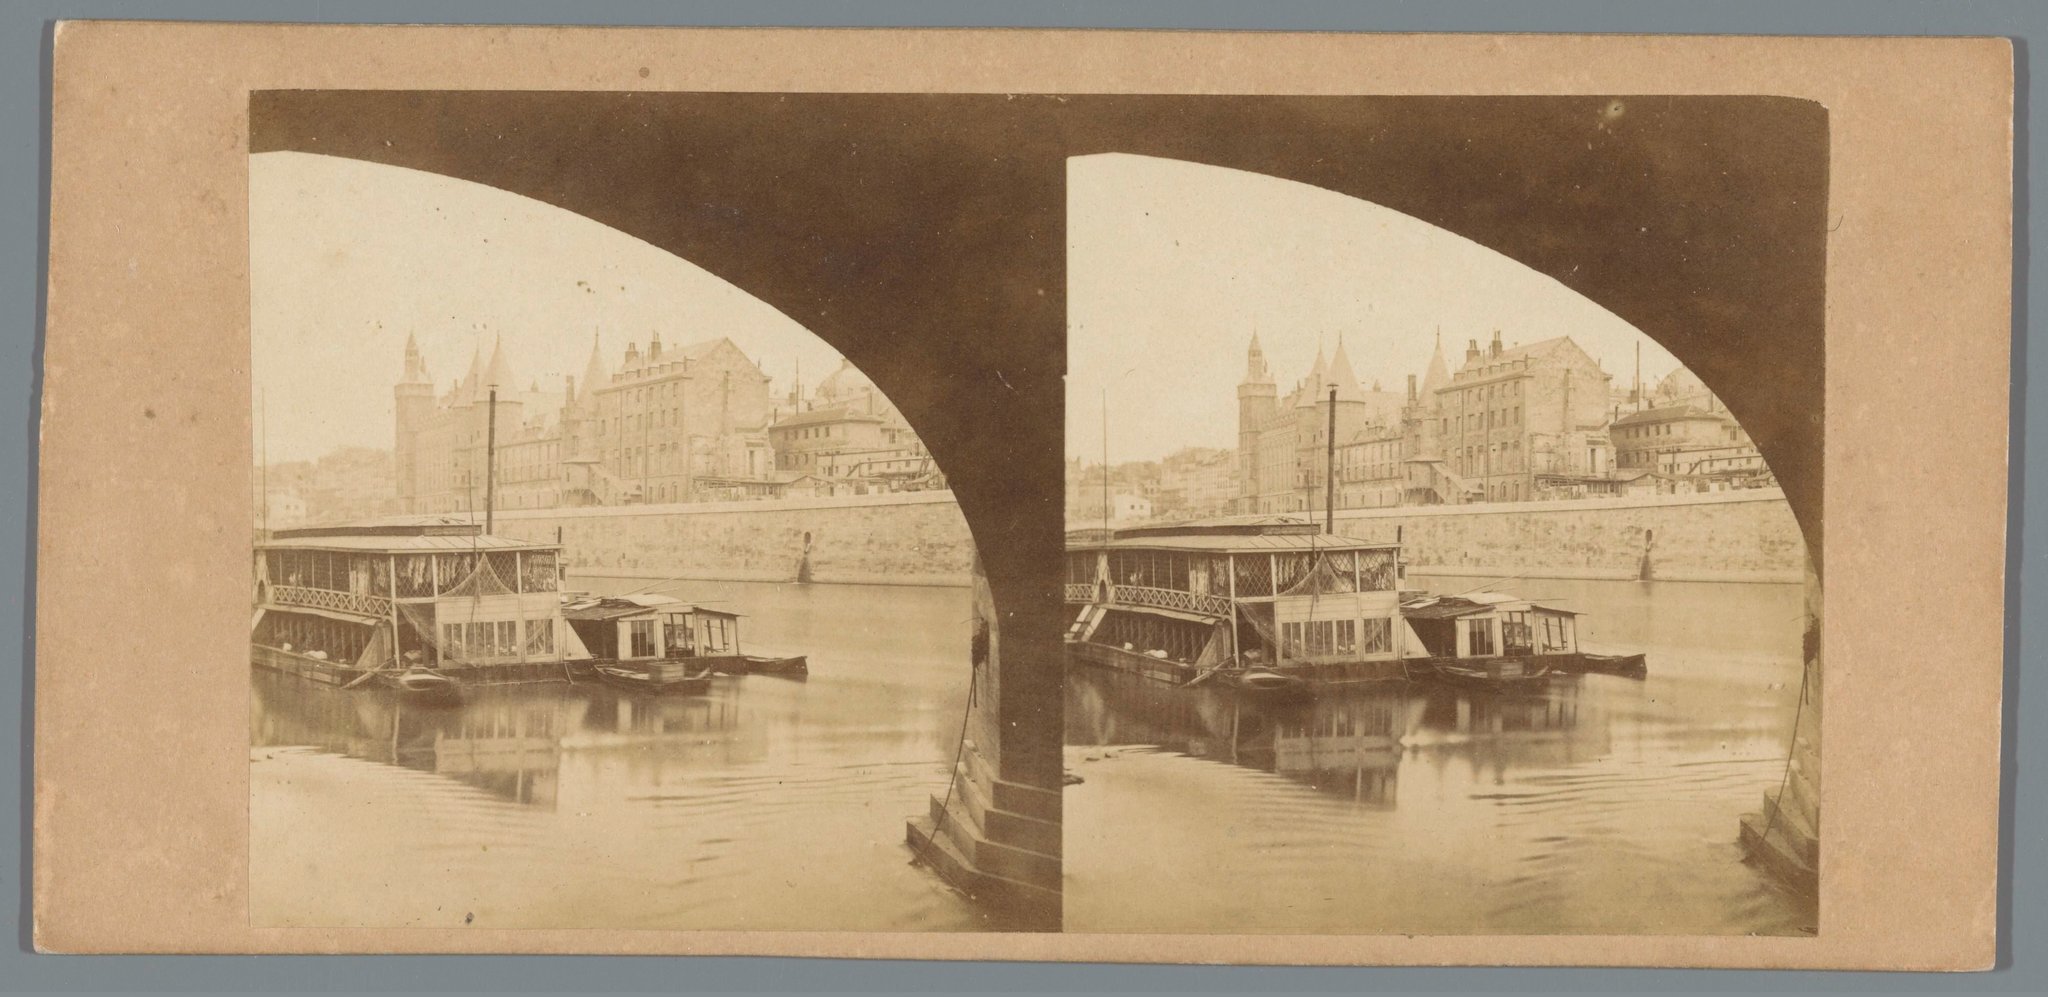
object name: stereograph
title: Gezicht op het Palais de Justice door een boog van Pont Neuf in Parijs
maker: Anonymous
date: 1850-1880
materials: cardboard, photographic support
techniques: albumen print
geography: paris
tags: court building, bridge in city across river, canal, etc.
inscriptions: number: ‘P. 20’, inscription: ‘Palais de Justice 4 gezien door boog van Pont Neuf’